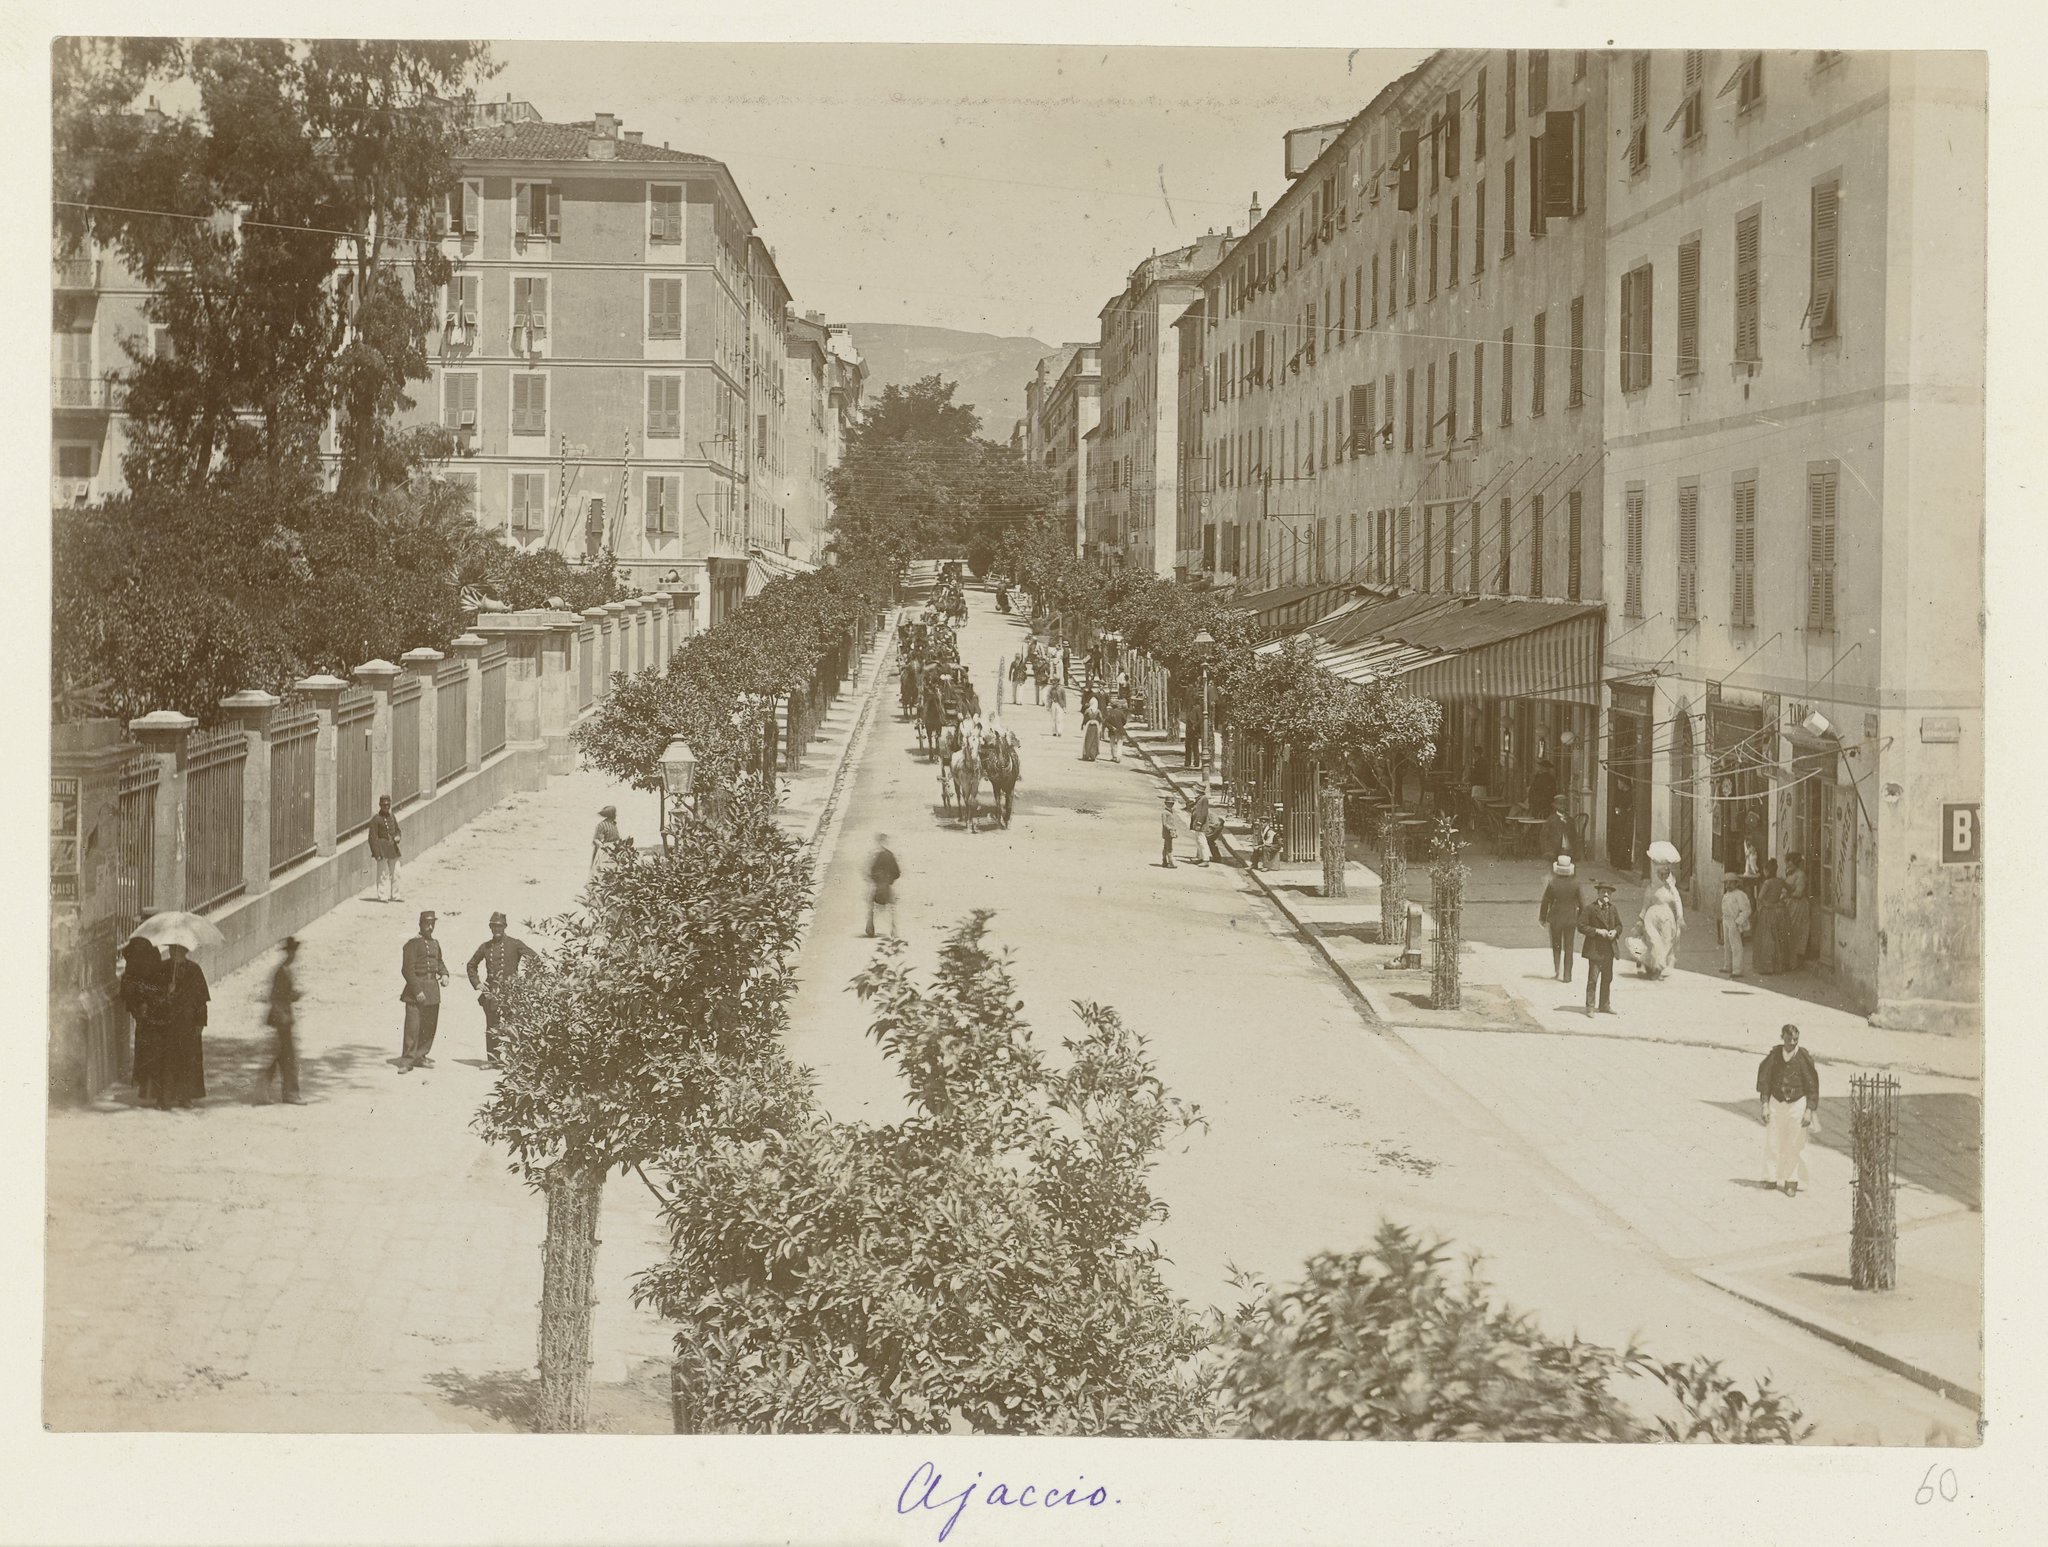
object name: photograph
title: Ajaccio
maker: henry pauw van wieldrecht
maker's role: fotograaf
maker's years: 1863-1912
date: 1886-1896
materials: cardboard, photographic support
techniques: albumen print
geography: corsica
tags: ajaccio